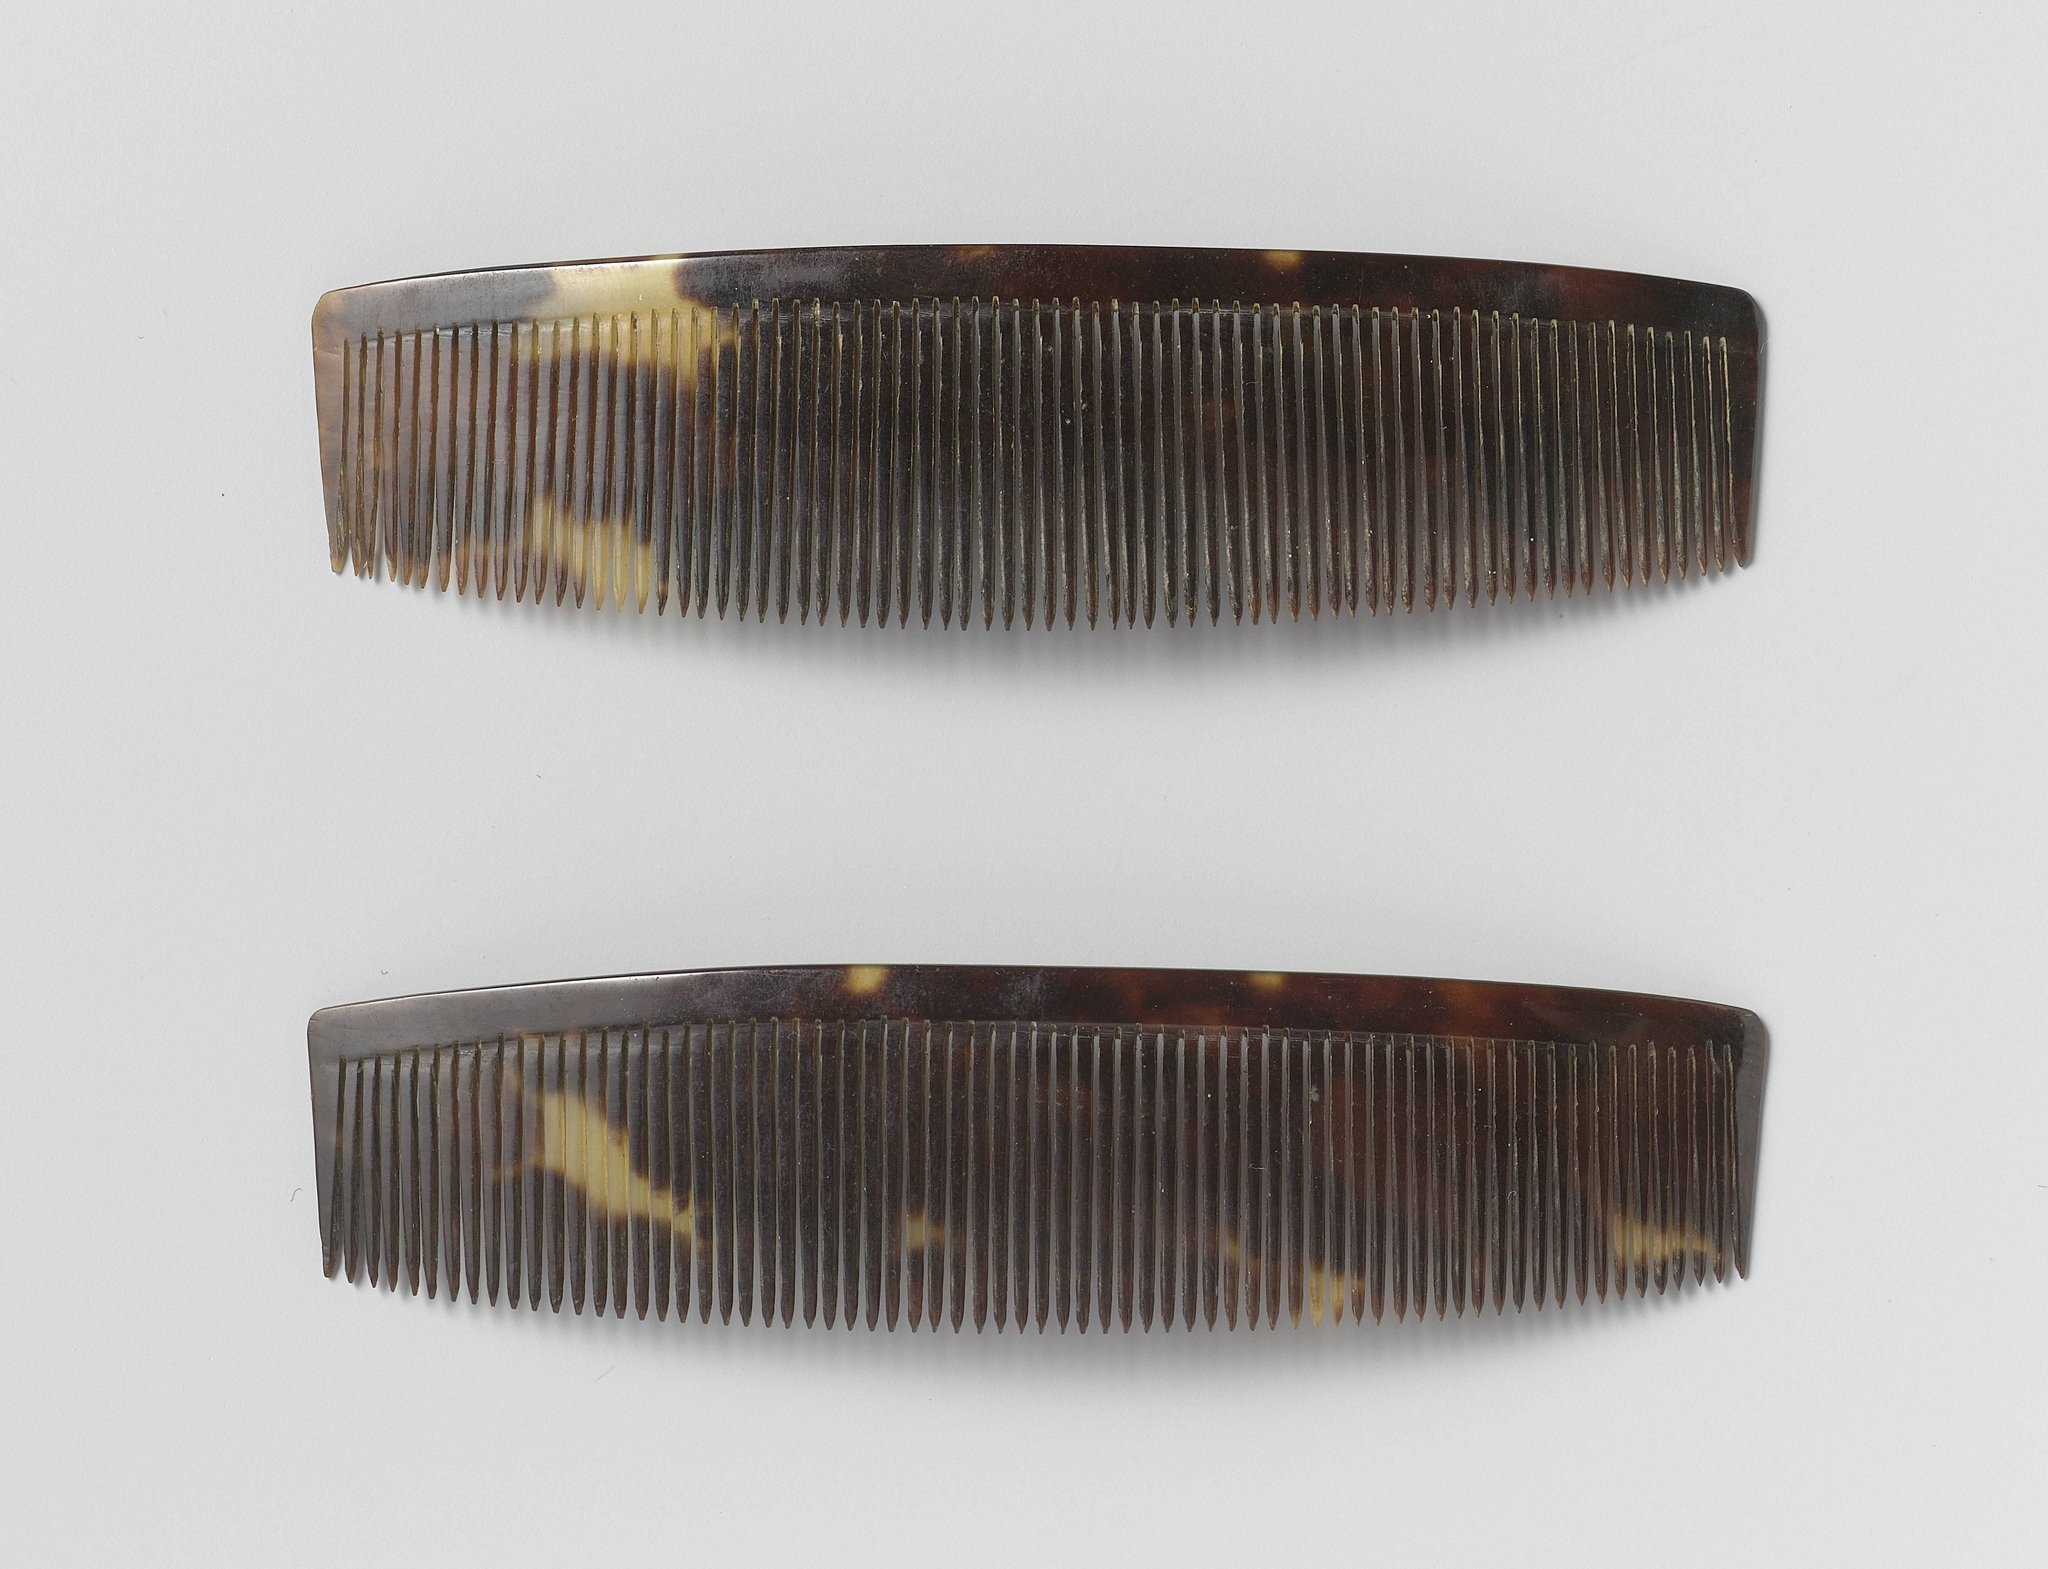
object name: comb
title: Haarkam of kam van effen fijne schildpad, met een lange rij smalle tanden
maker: Anonymous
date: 1800-1899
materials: shell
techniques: filing, polish, pressing, sawing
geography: netherlands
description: Haarkam of kam van effen fijne schildpad, met een lange rij smalle tanden